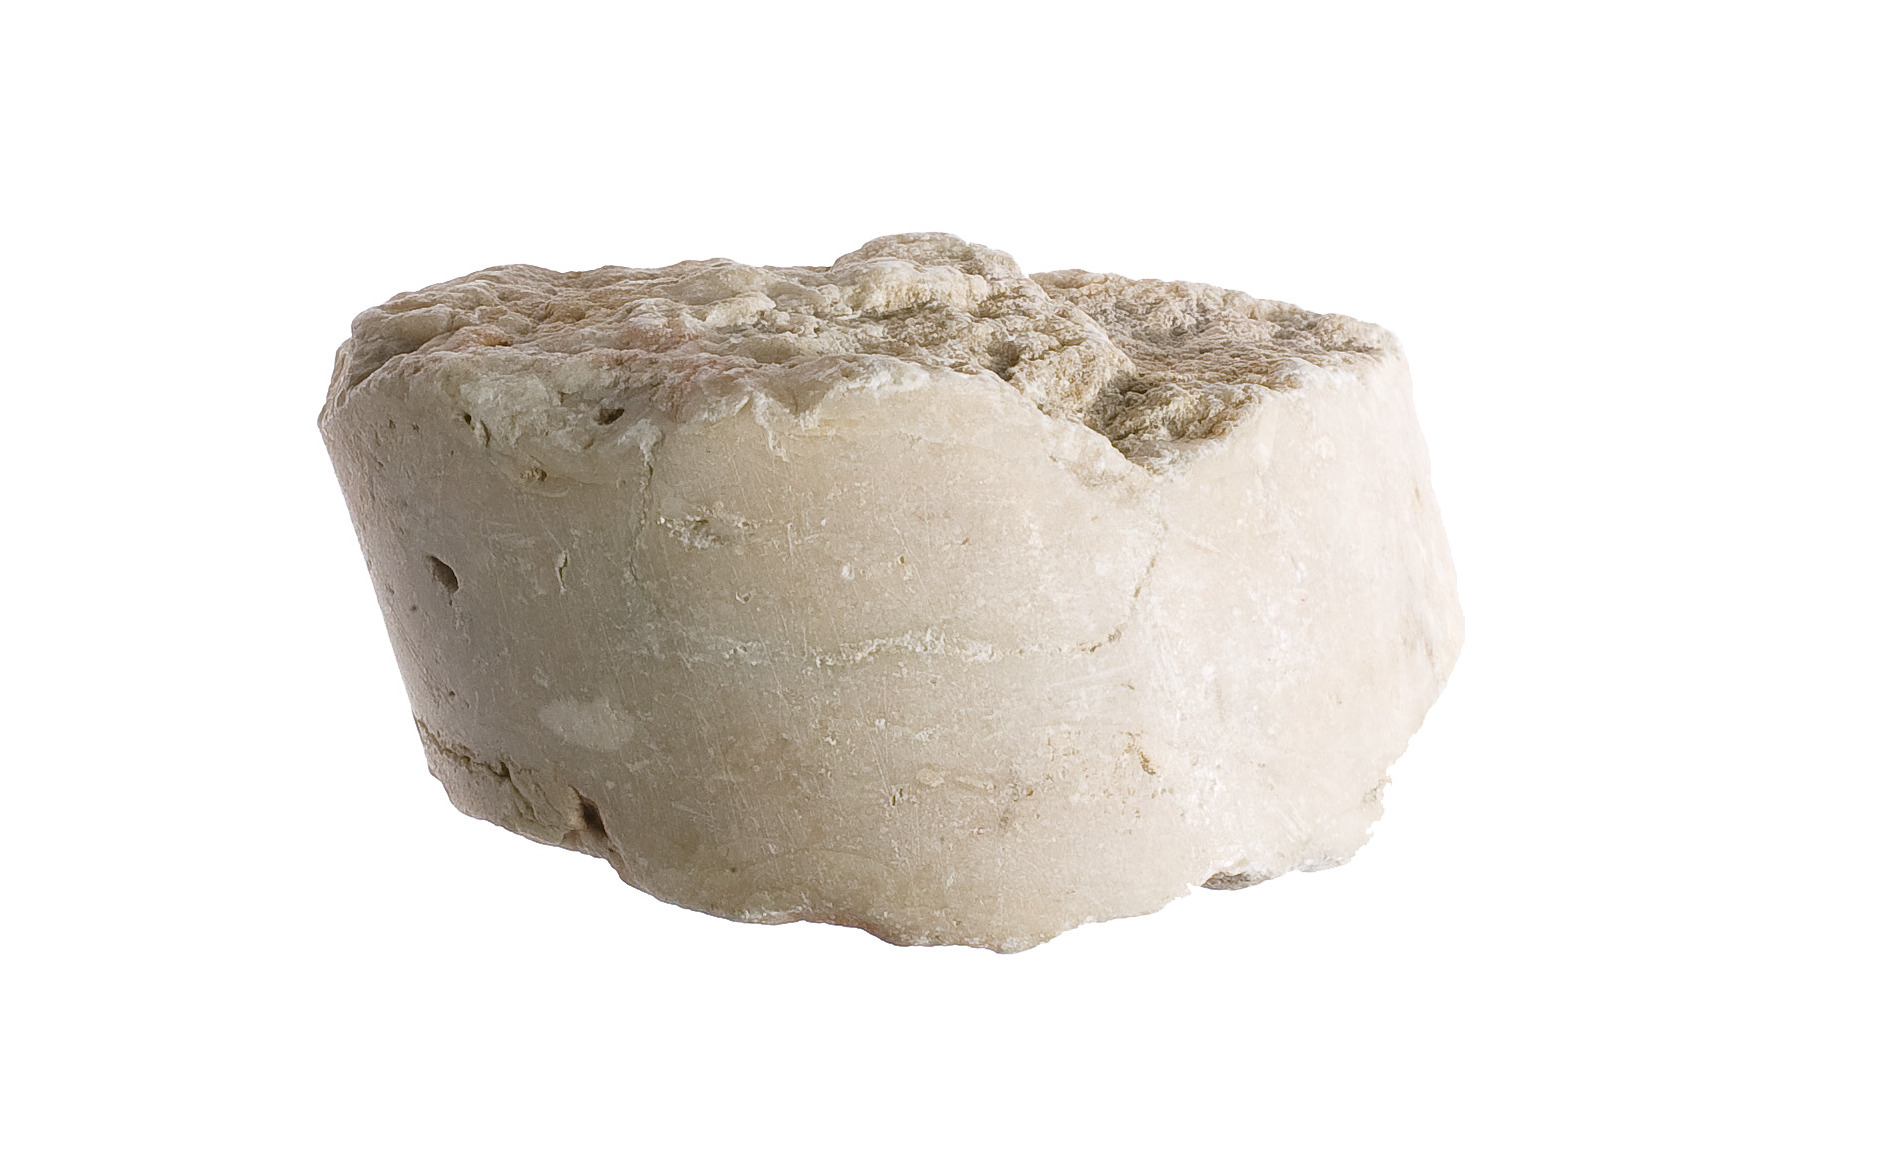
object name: arm fragment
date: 1353-1336 BCE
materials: limestone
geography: egypt